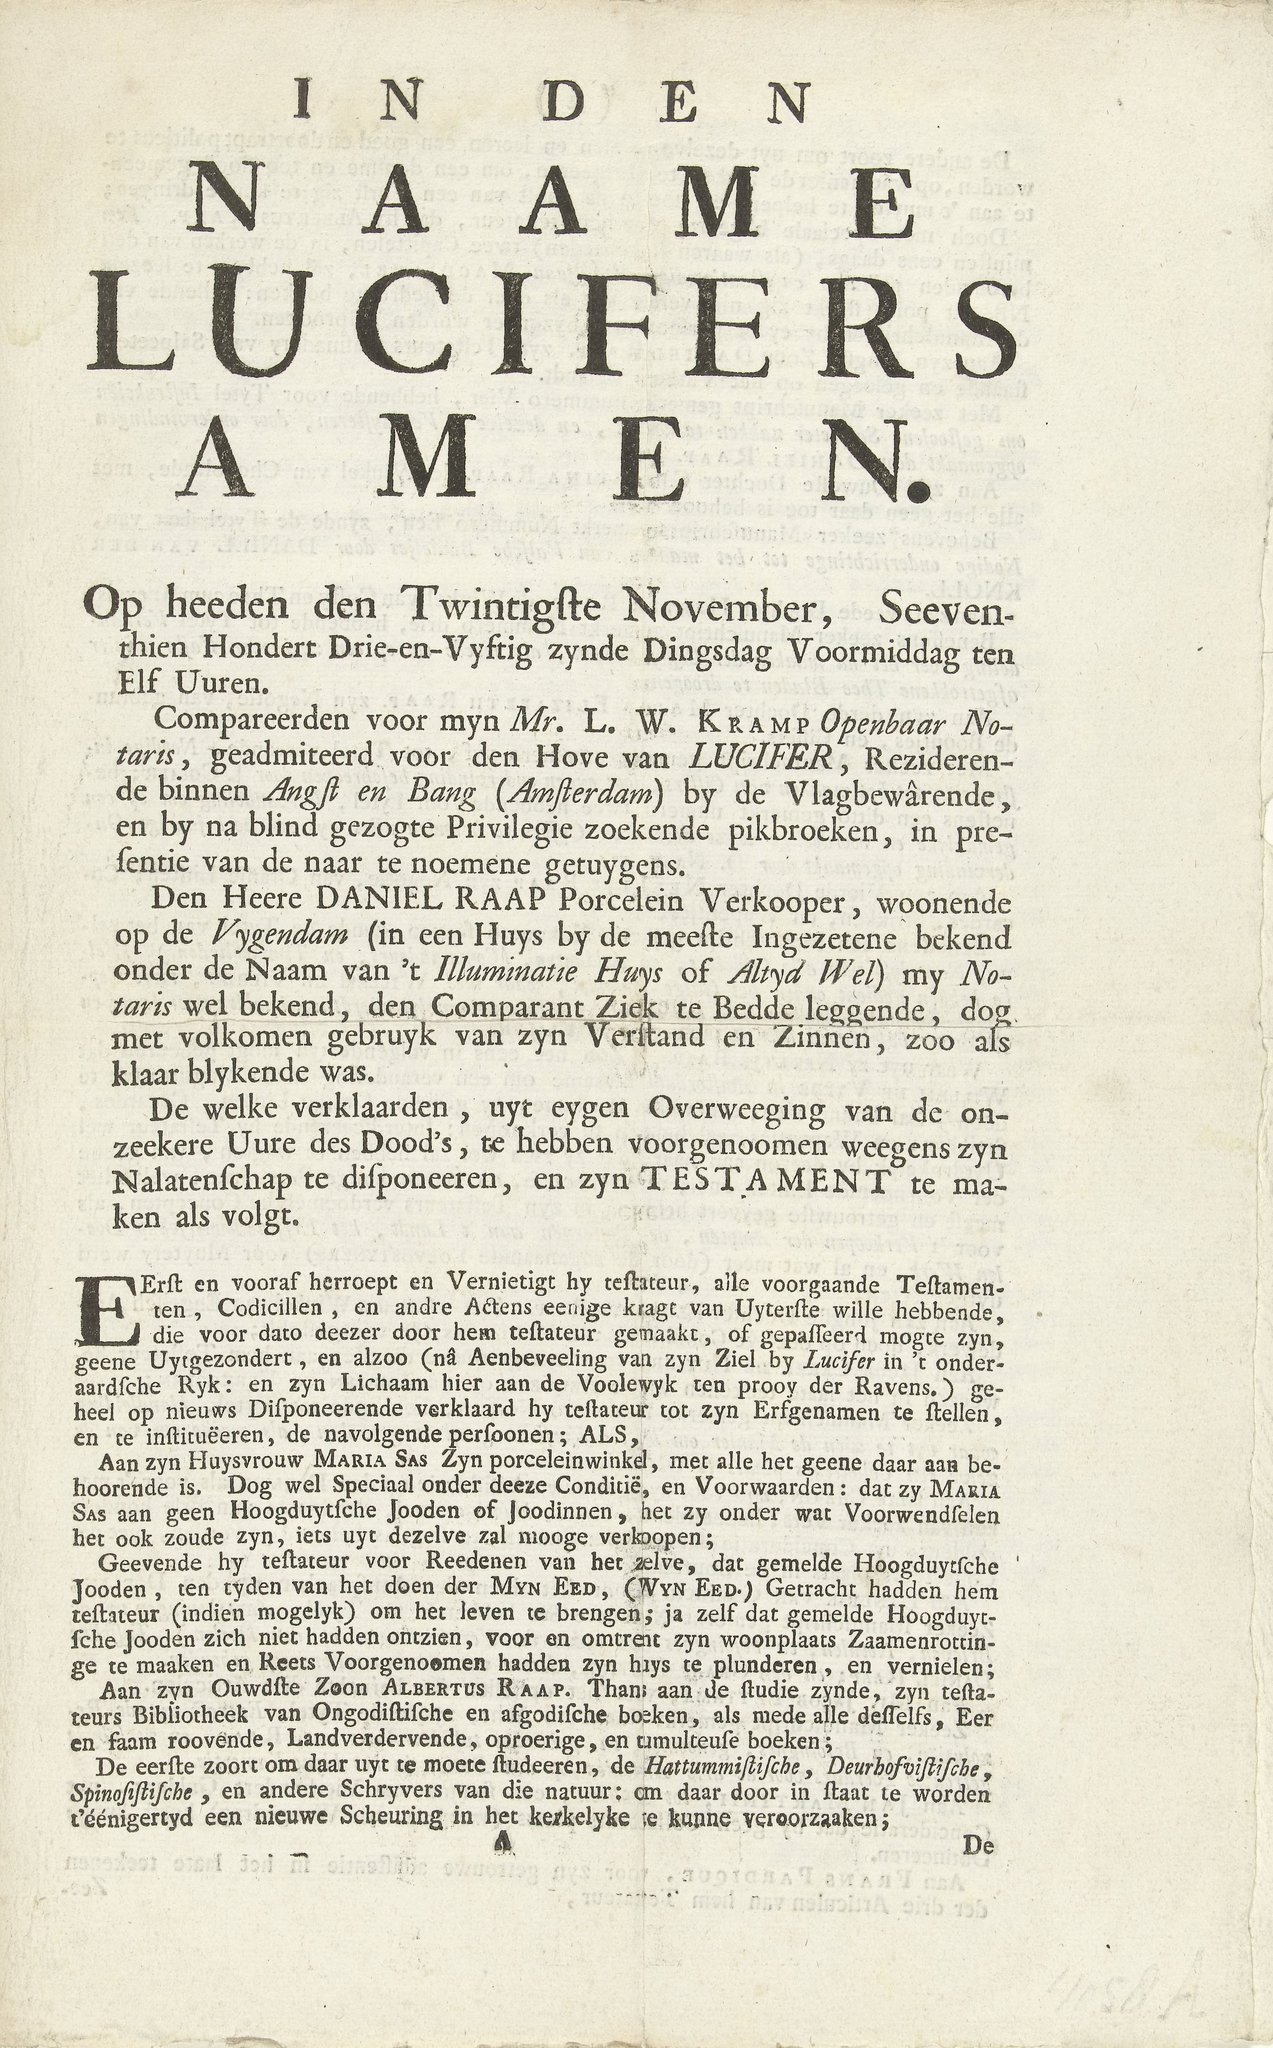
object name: will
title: Copia. Testament of Uyterste Wille van den Heere Daniel Raap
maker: Anonymous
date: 1754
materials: paper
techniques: letterpress printing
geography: northern netherlands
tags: amsterdam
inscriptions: collector's mark: Lugt 2228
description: Satirisch pamflet in de vorm van het testament van Daniël Raap, overleden op 15 januari 1754 te Amsterdam. Dubbelgevouwen blad bedrukt met tekst op vier zijden met de titel en het testament opgesteld door de notaris L.W. Kramp.